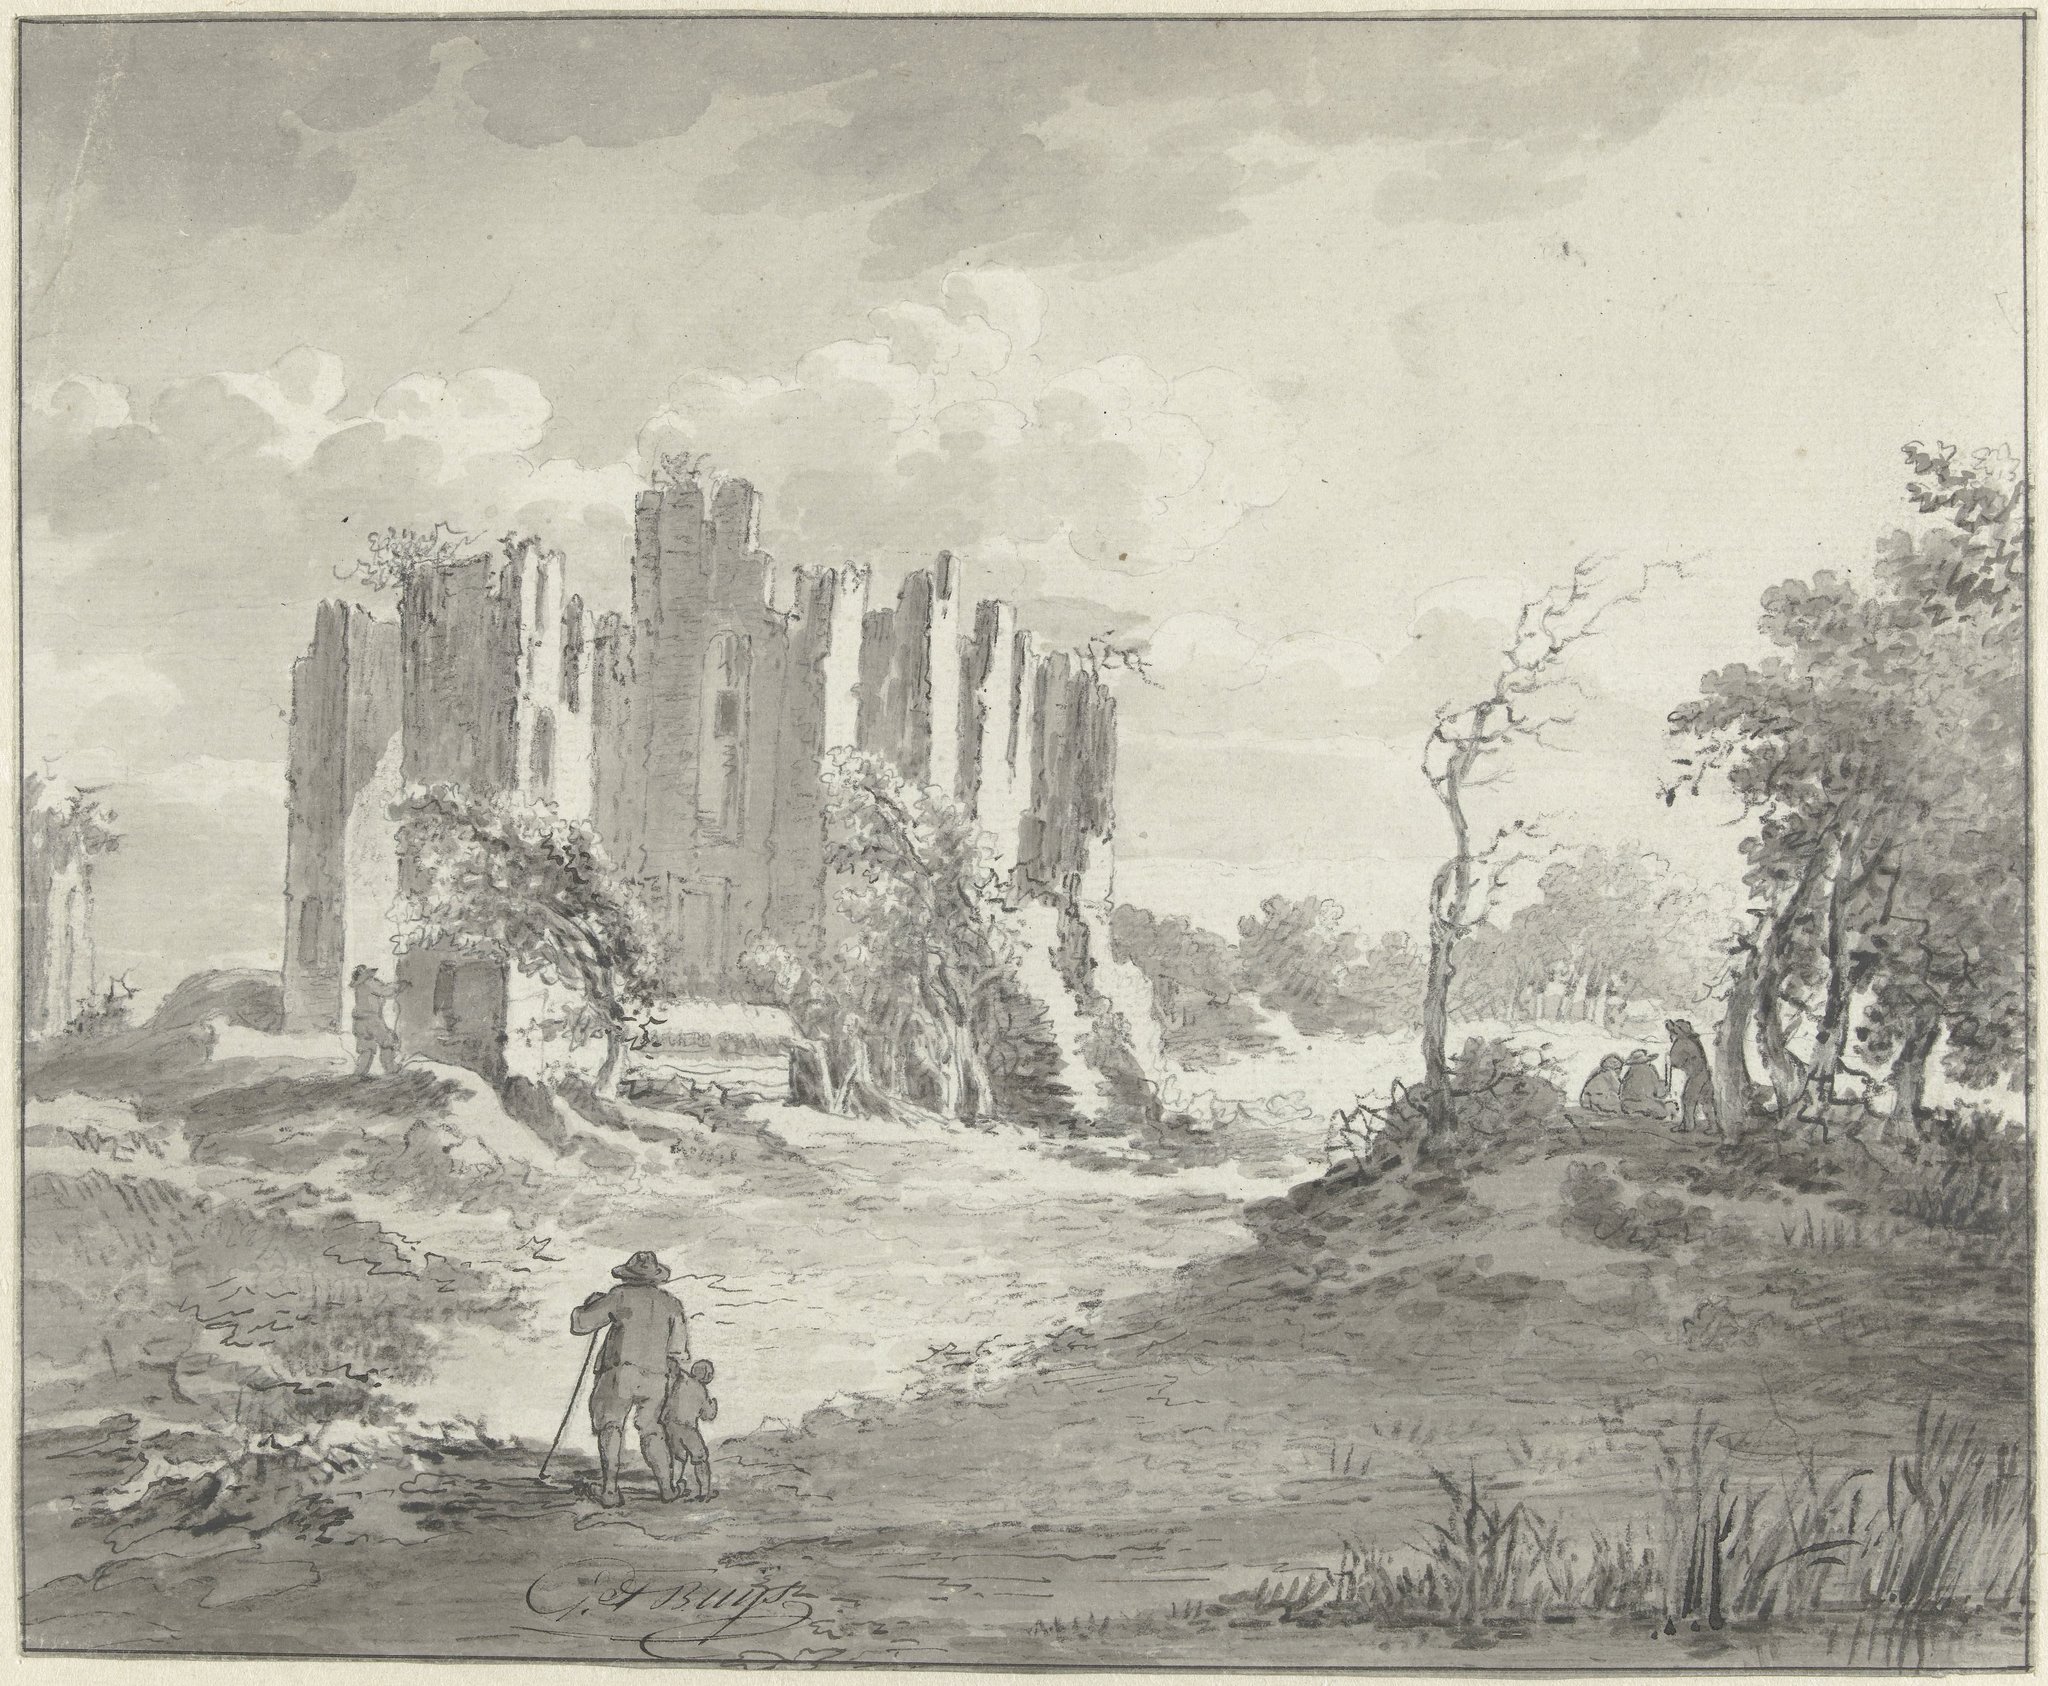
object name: drawing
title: Landschap met bouwval en enige boeren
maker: g.f. buijs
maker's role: draughtsman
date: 1700-1800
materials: chalk, ink, paper, pencil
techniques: brush, pen